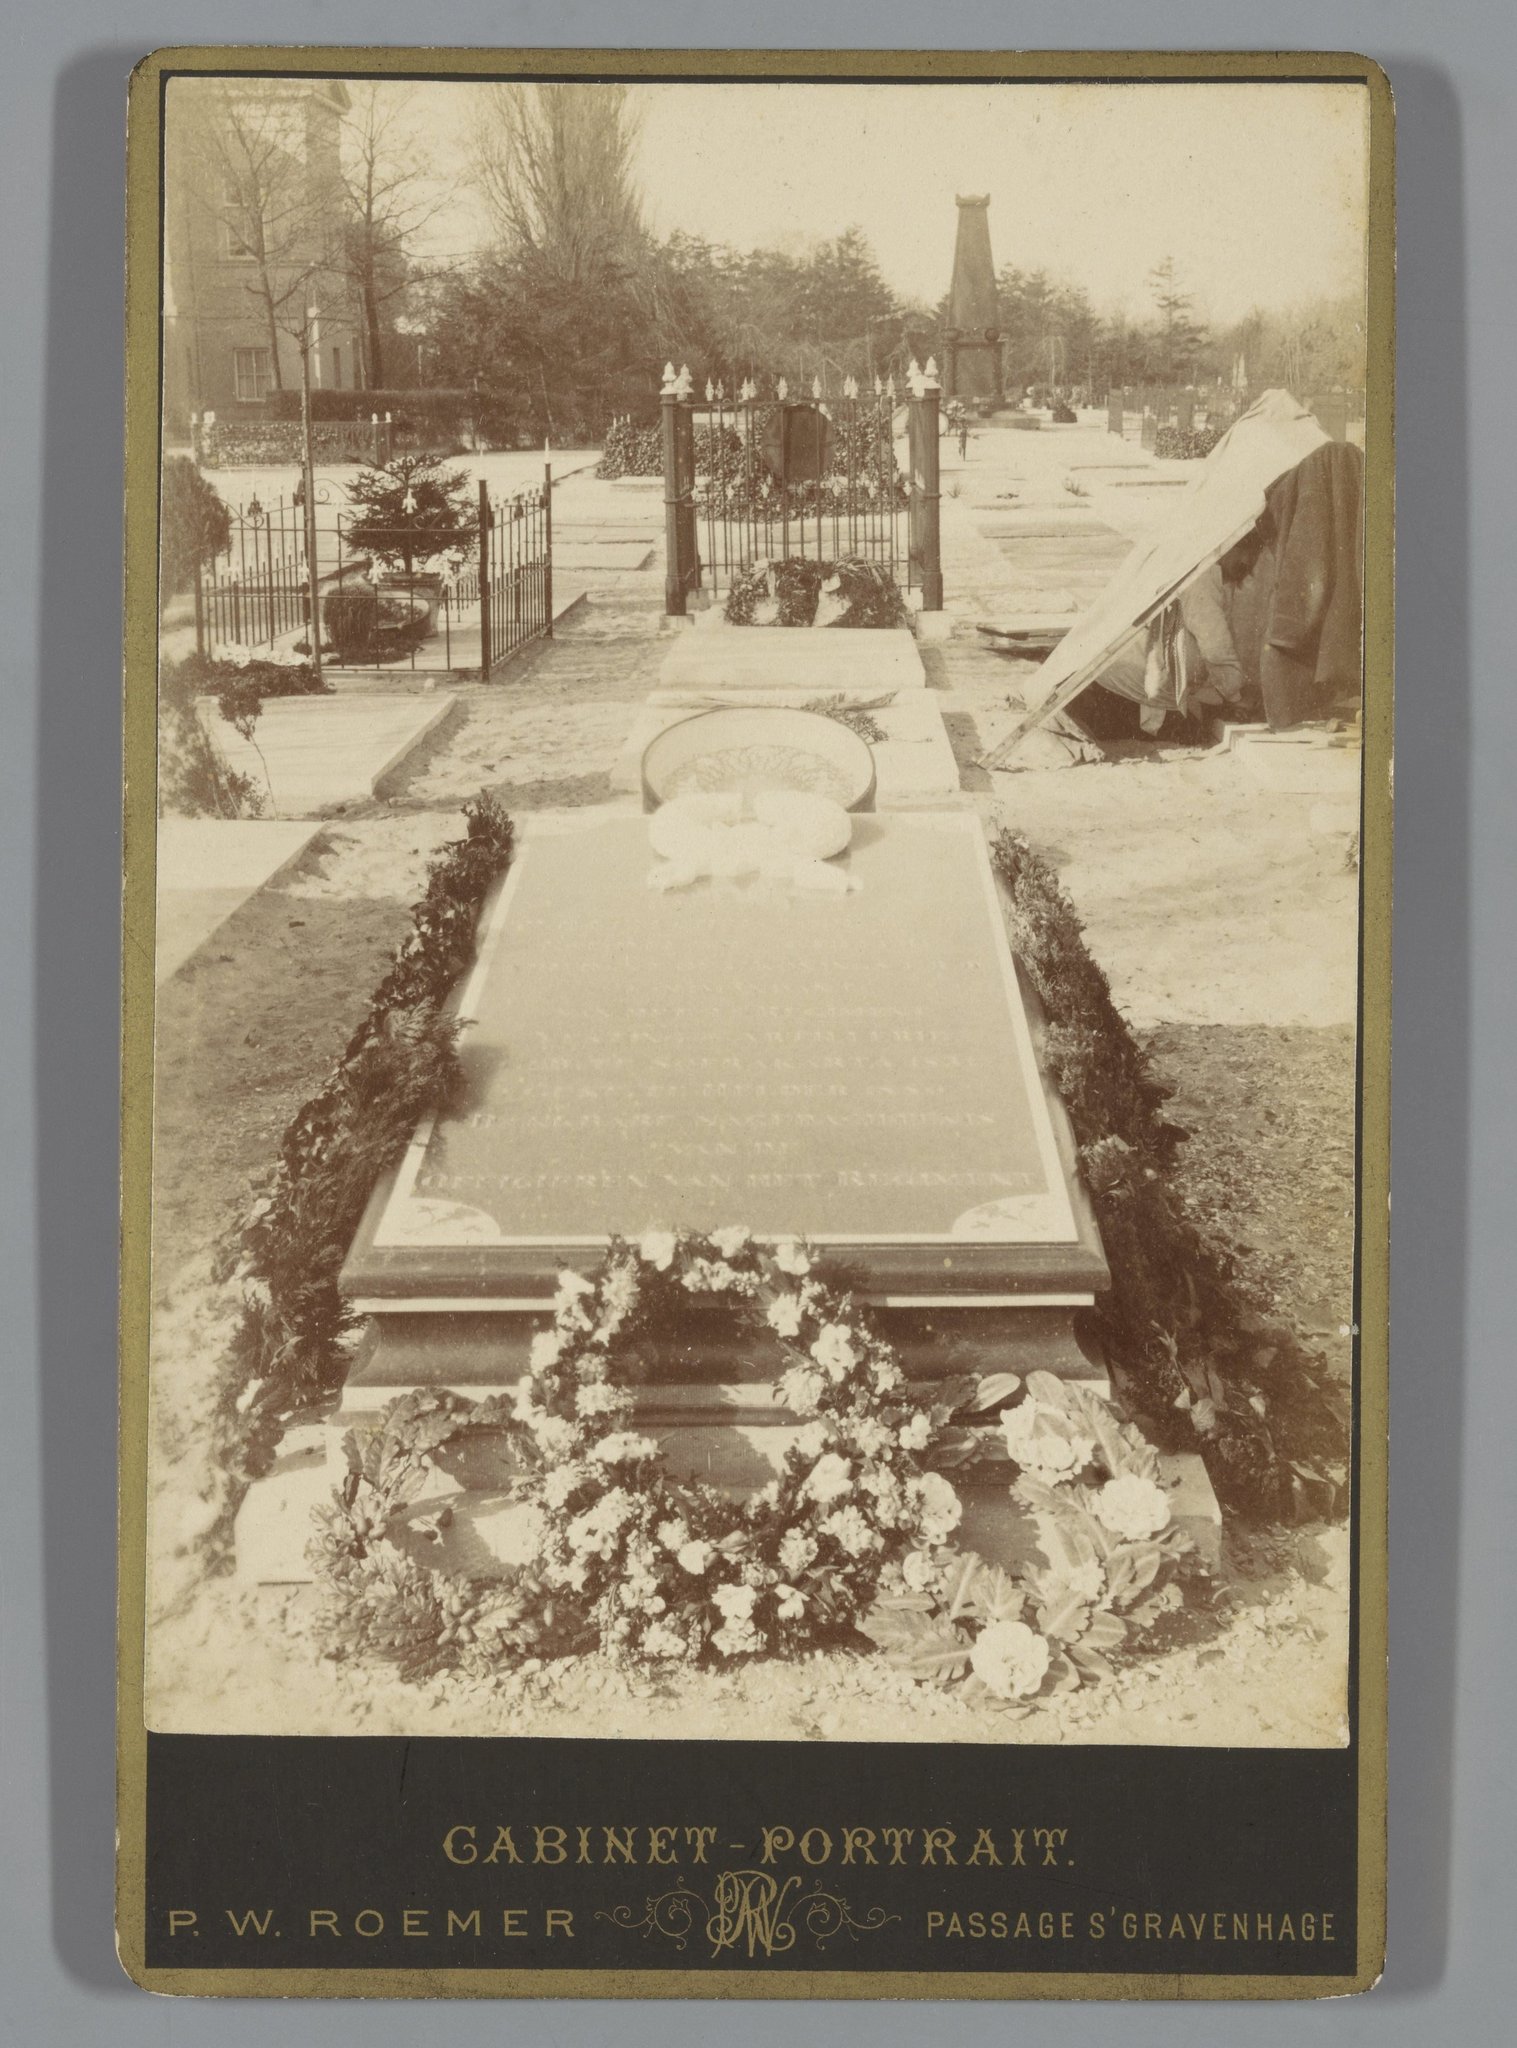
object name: cabinet photograph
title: Graf van een officier, Nederland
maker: pieter wilhelmus roemer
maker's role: fotograaf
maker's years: 1838-1924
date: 1870-1890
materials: cardboard, paper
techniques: albumen print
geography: netherlands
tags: gravestone, tombstone, cemetery, park-like burying ground, netherlands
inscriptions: inscription: ‘Photographie Artistique/ van/ P.W. Roemer (...) De plaat blijft ter nabestelling bewaard.’, collector's mark: ‘Vosmaer’